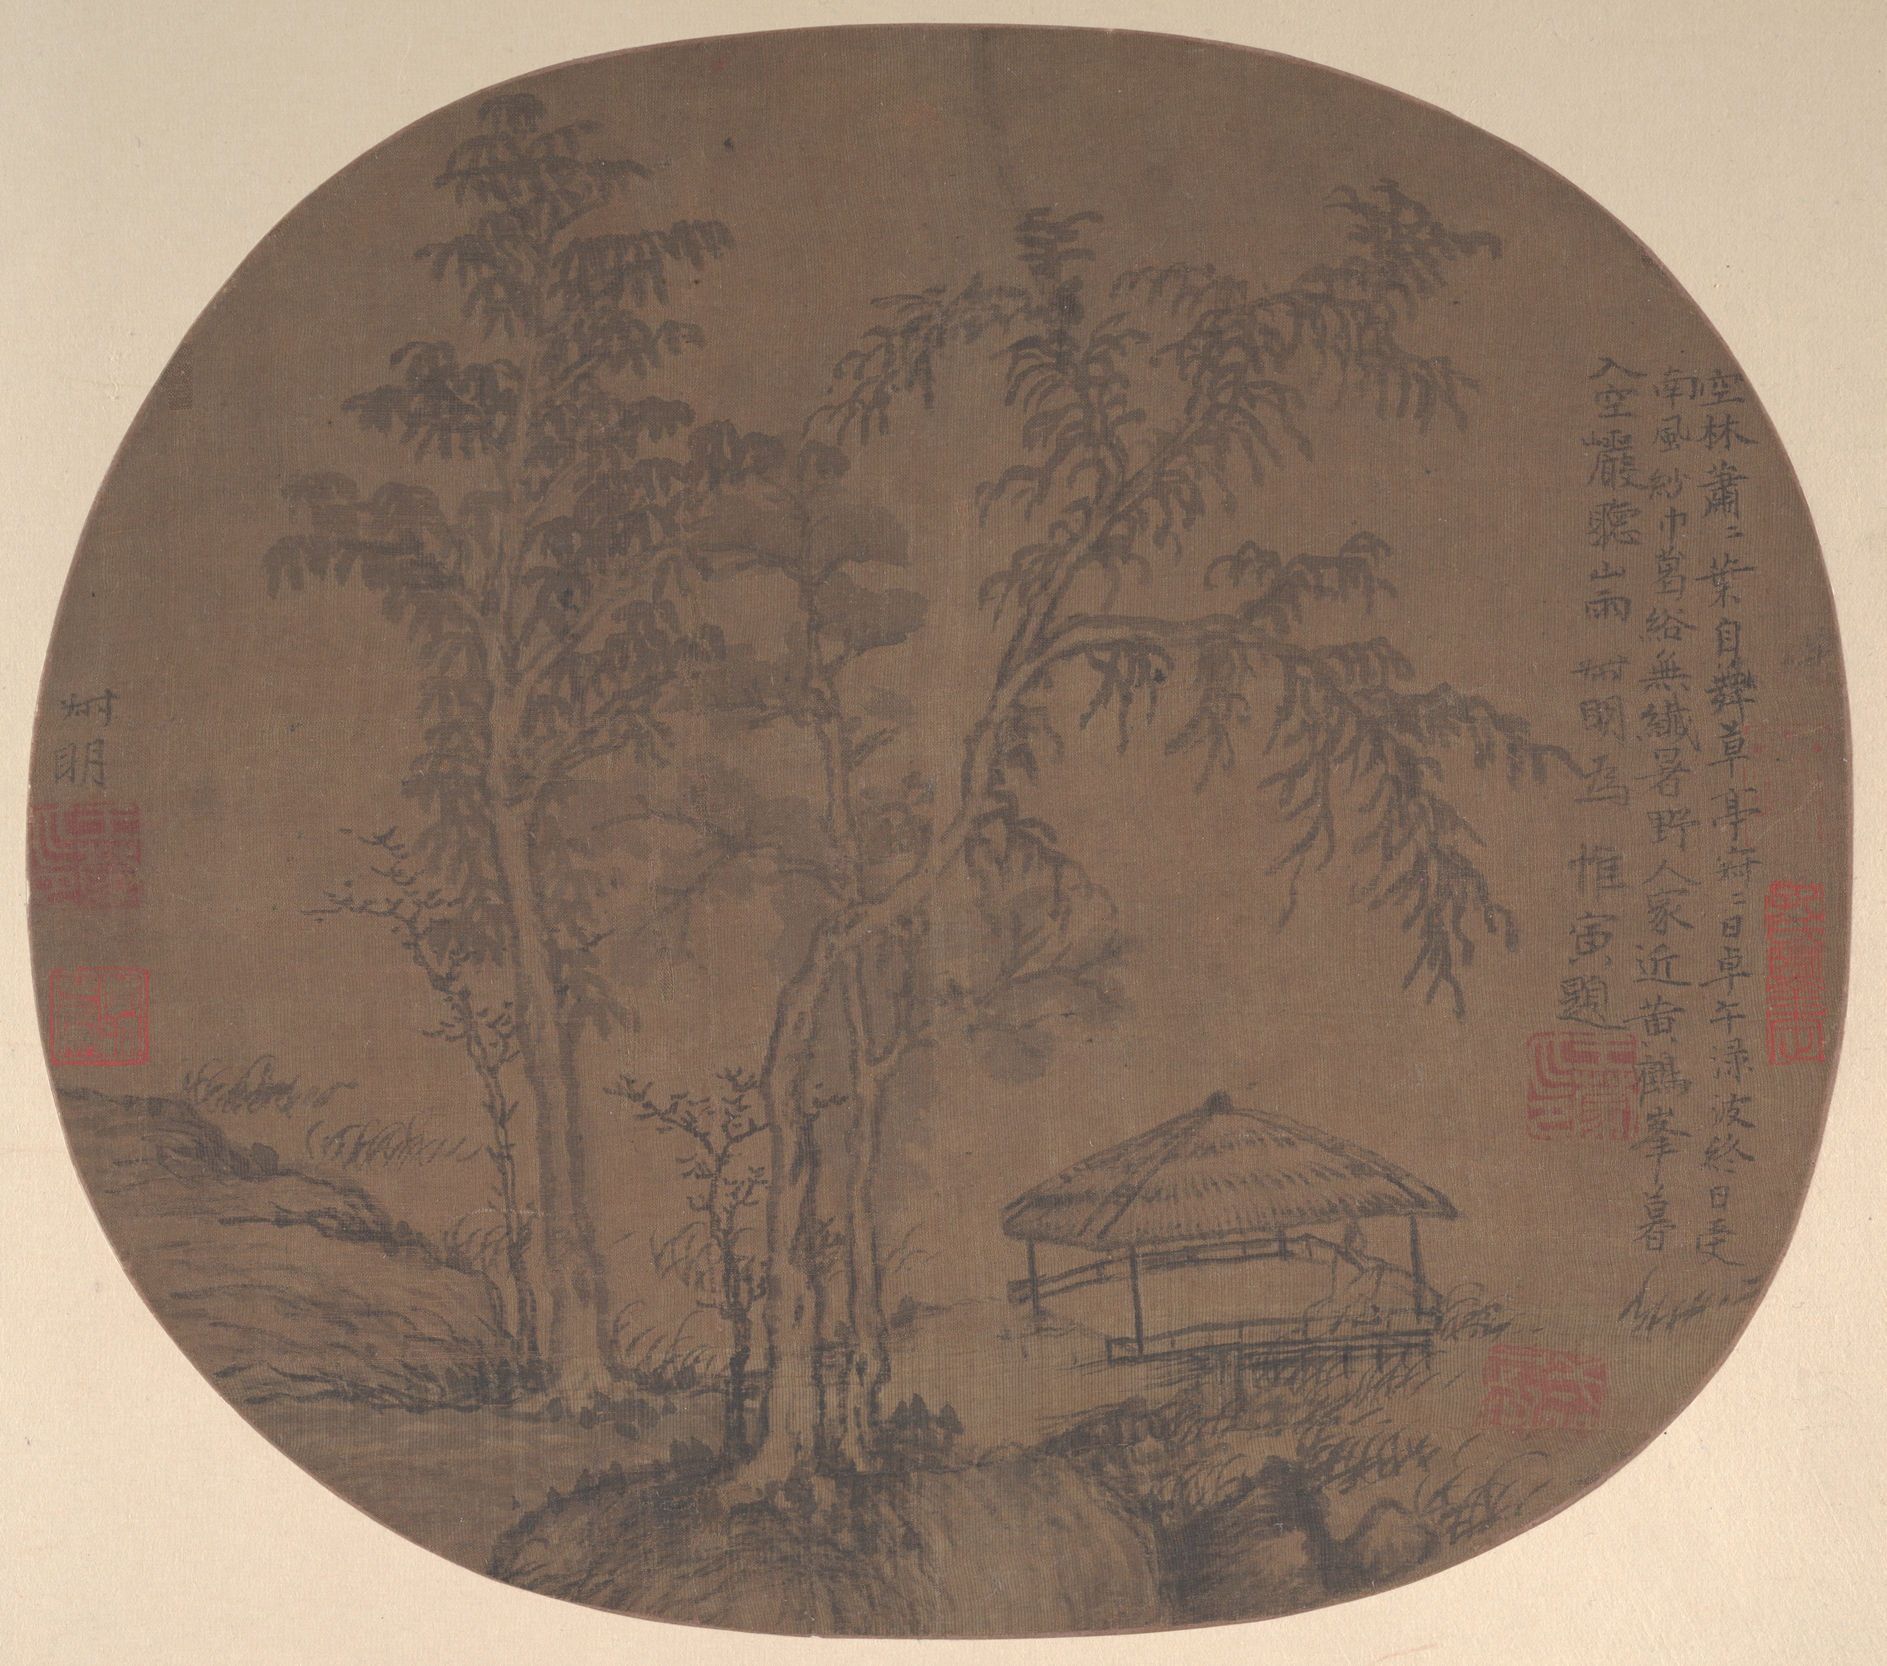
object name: fan mounted a an album leaf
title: Sparse trees and pavilion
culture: chinese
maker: wang meng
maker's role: artist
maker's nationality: chinese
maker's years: 1308-1385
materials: ink, silk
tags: trees,pavilions